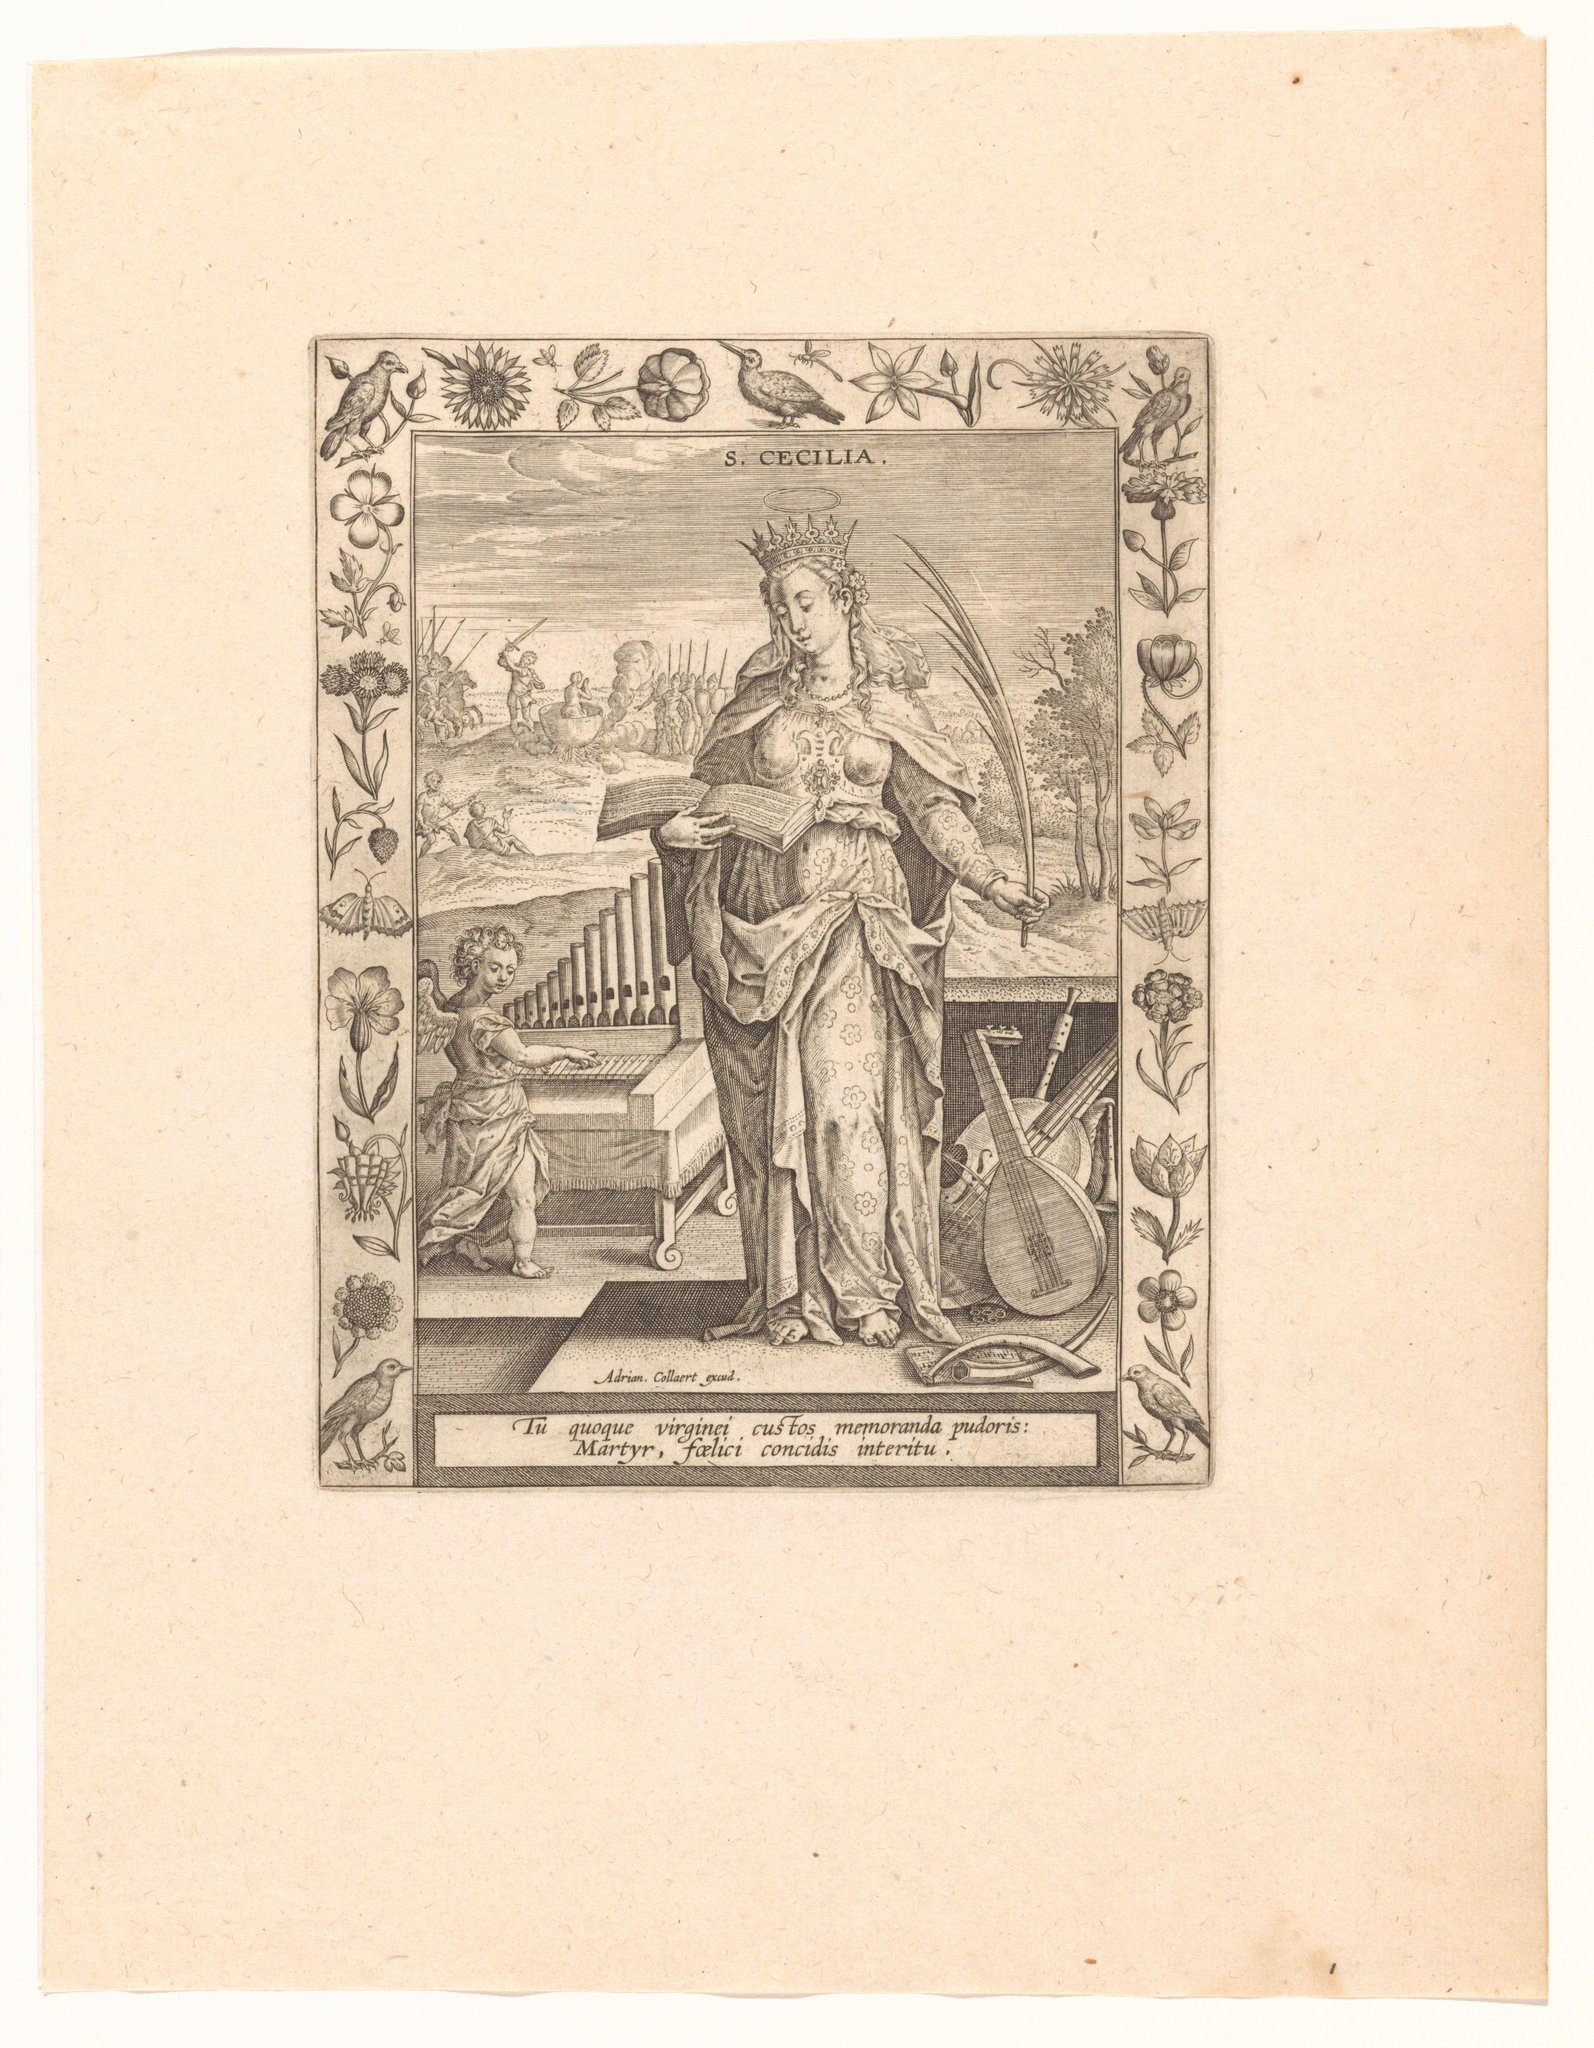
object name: print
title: Heilige Cecilia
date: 1590-1610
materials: paper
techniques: engraving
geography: antwerp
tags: the virgin martyr cecilia of rome; possible attributes: falcon, musical instruments, organ, wreath of roses and lilies, flowers, musical instruments; group of musical instruments, birds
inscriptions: collector's mark: Lugt 3751, collector's mark: Lugt 2760, collector's mark: Lugt 2228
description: Heilige Cecilia met muziekinstrumenten. Onderdeel van een serie van 24 voorstellingen van vrouwelijke martelaren (martyrologium). De voorstellingen zijn voorzien van randen met bloemen en dieren.